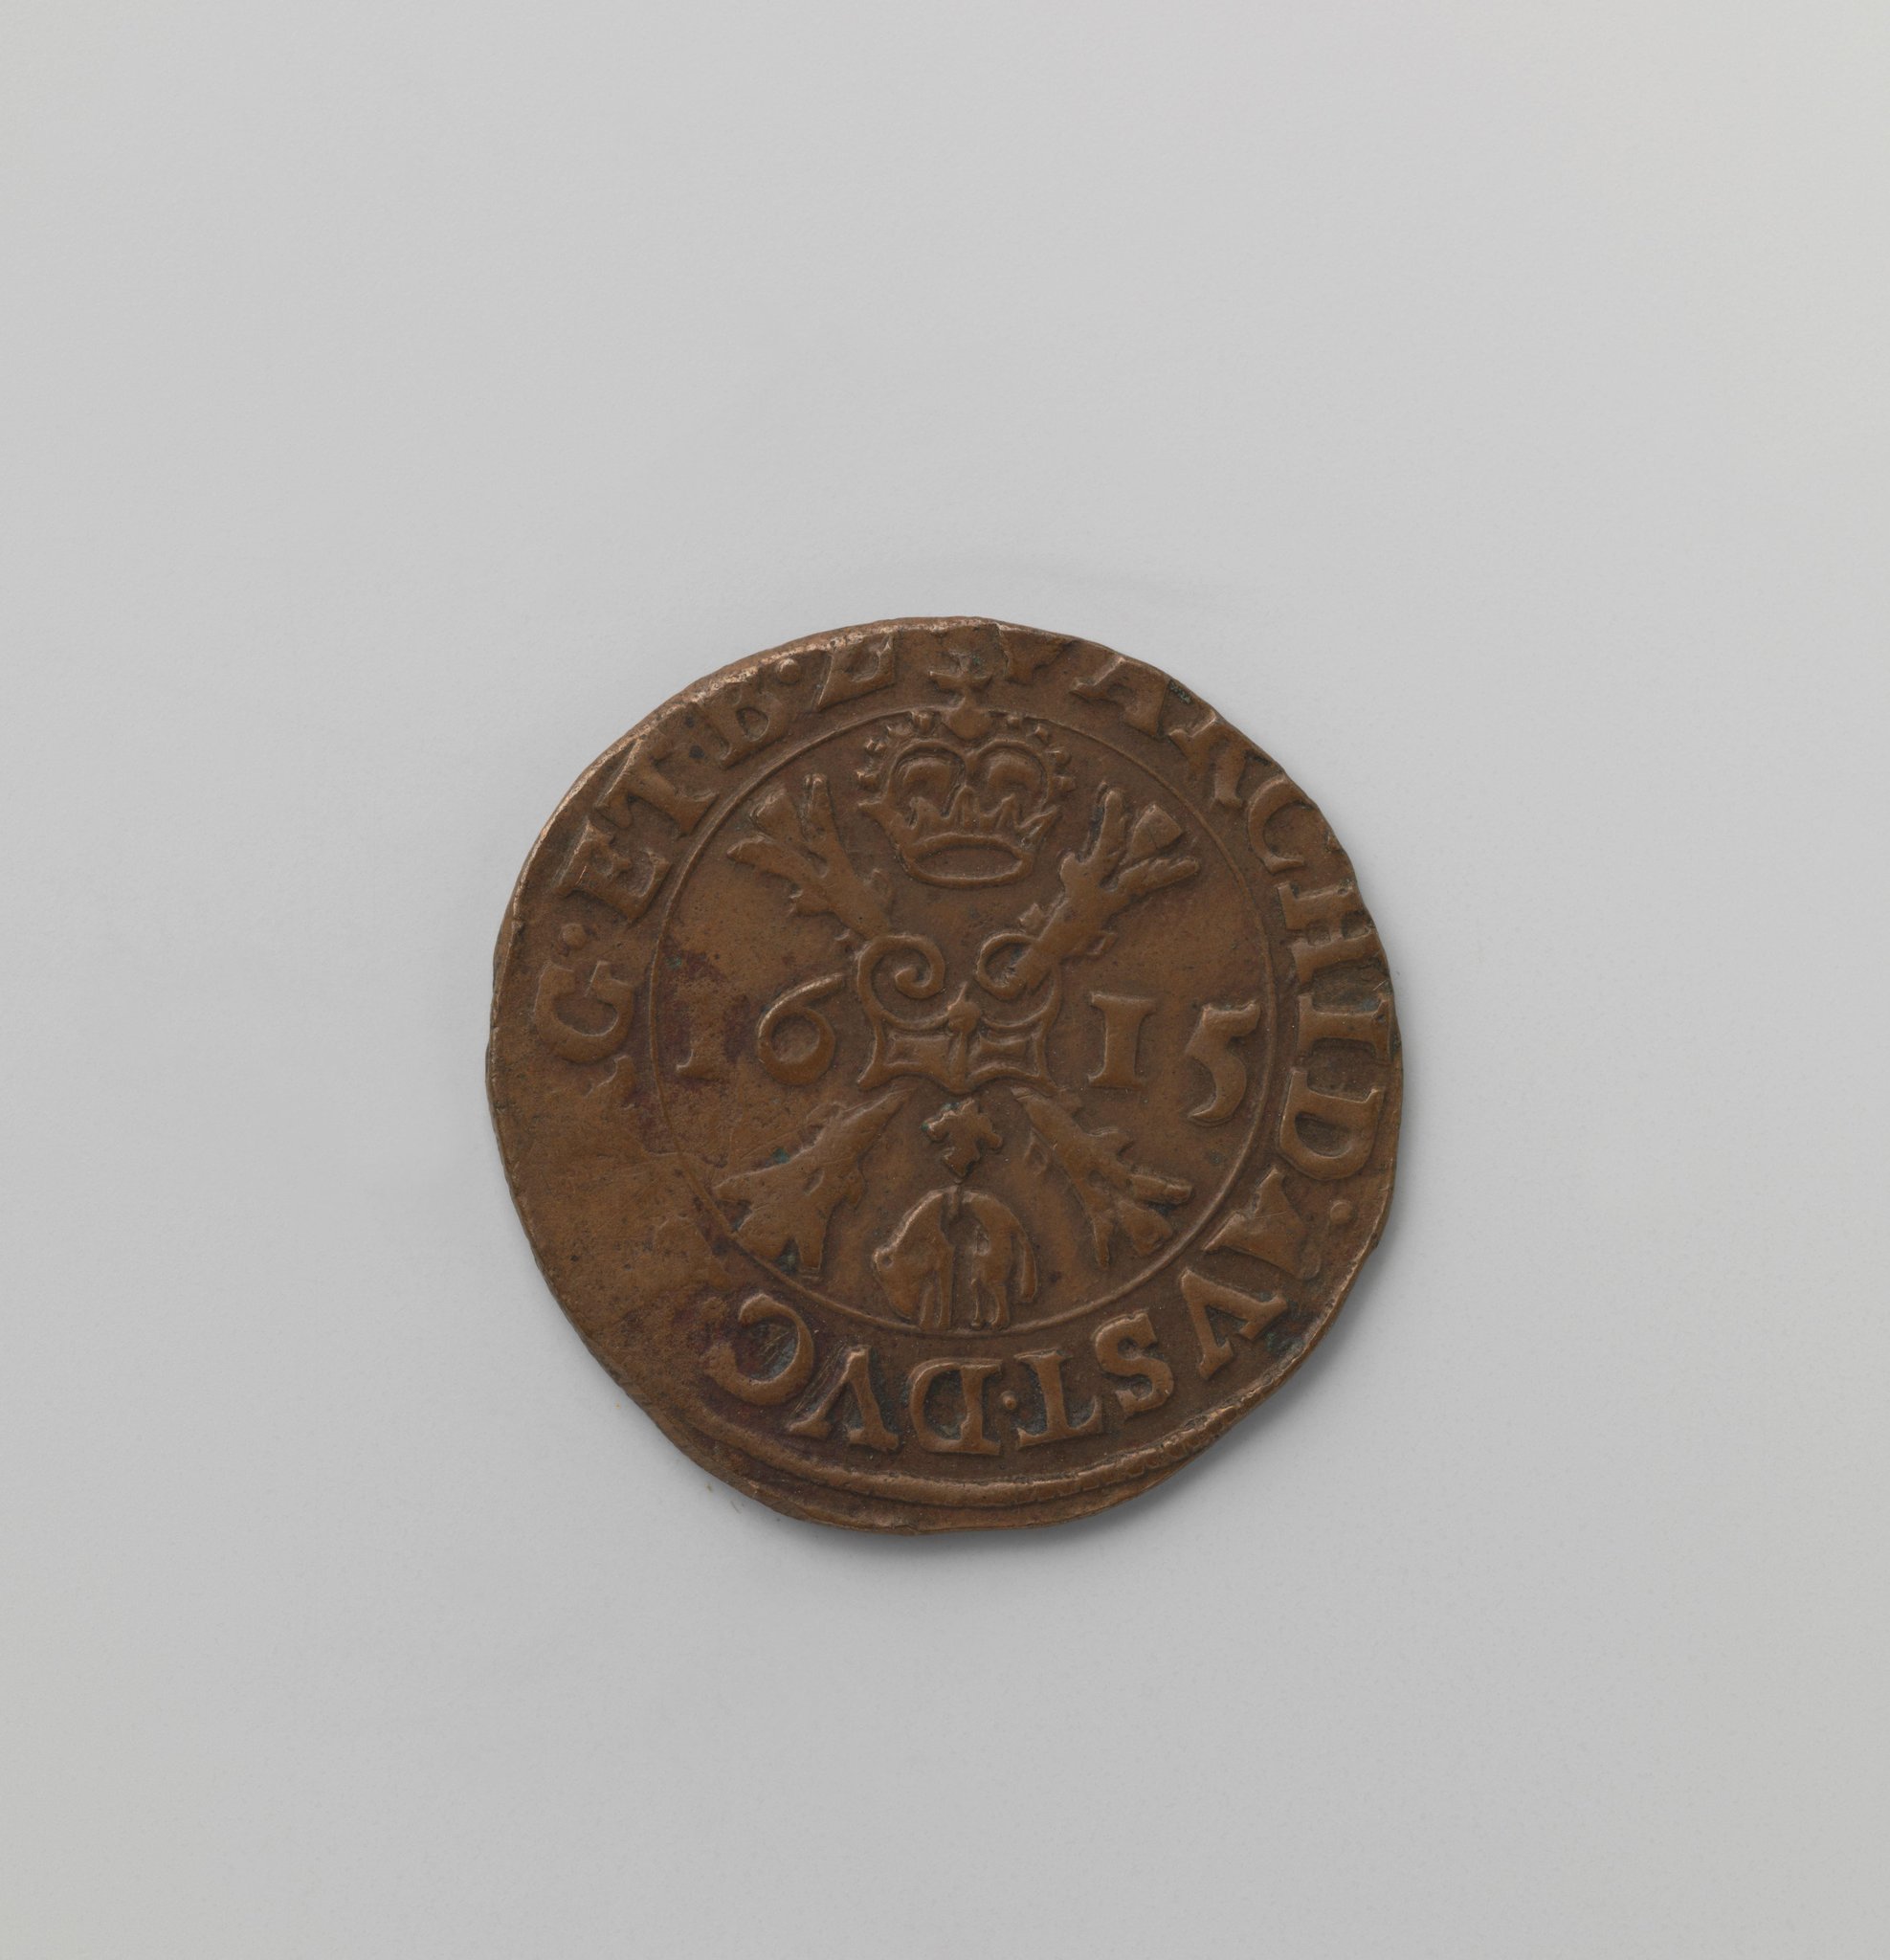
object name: coin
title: Duit uit Brabant van Albert en Isabella, 1615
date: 1615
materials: copper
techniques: striking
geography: antwerp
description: Koperen munt. Voorzijde: gekroond versierd samengesteld wapenschild. Hand aan het begin van het omschrift. Keerzijde: tussen jaartal vuurijzer op stokkenkruis Daarboven kroon, daaronder gulden vlies. Hand aan het begin van het omschrift.